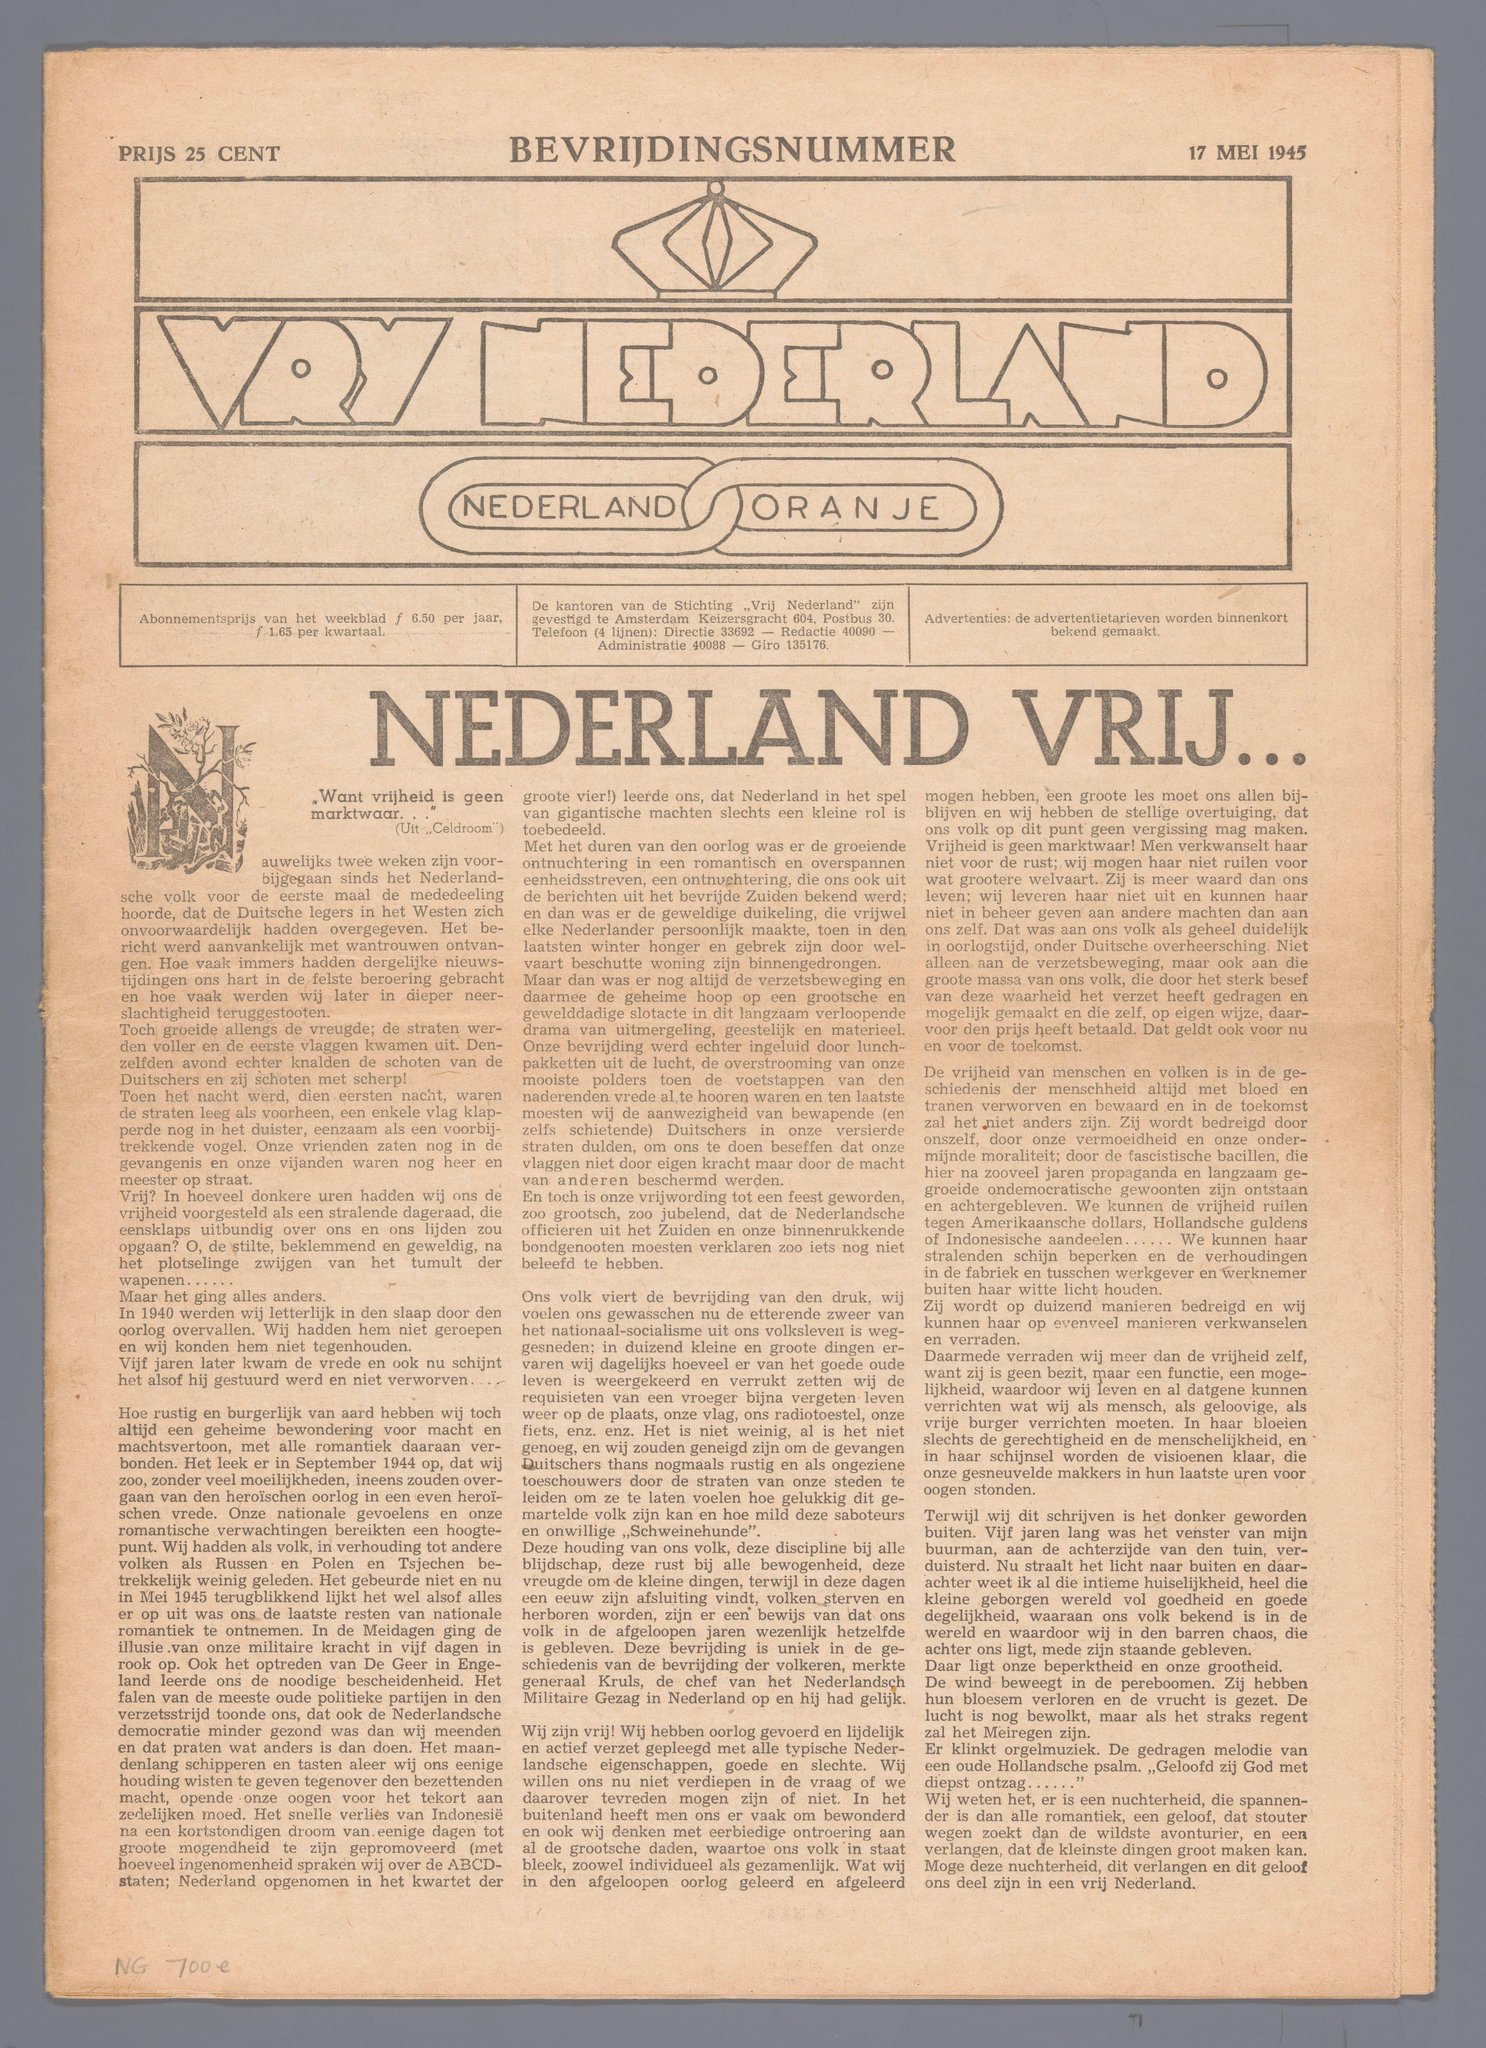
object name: newspaper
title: Vrij Nederland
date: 1945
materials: paper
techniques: printing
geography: amsterdam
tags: netherlands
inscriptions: date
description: Krant, bevrijdingsnummer van de 5e jaargang van het illegale blad 'Vrij Nederland", 16 pp. Opschrift; voorp.: 'Nederland Vrij...' Opmerking: Zie NG-700-B, C en D.